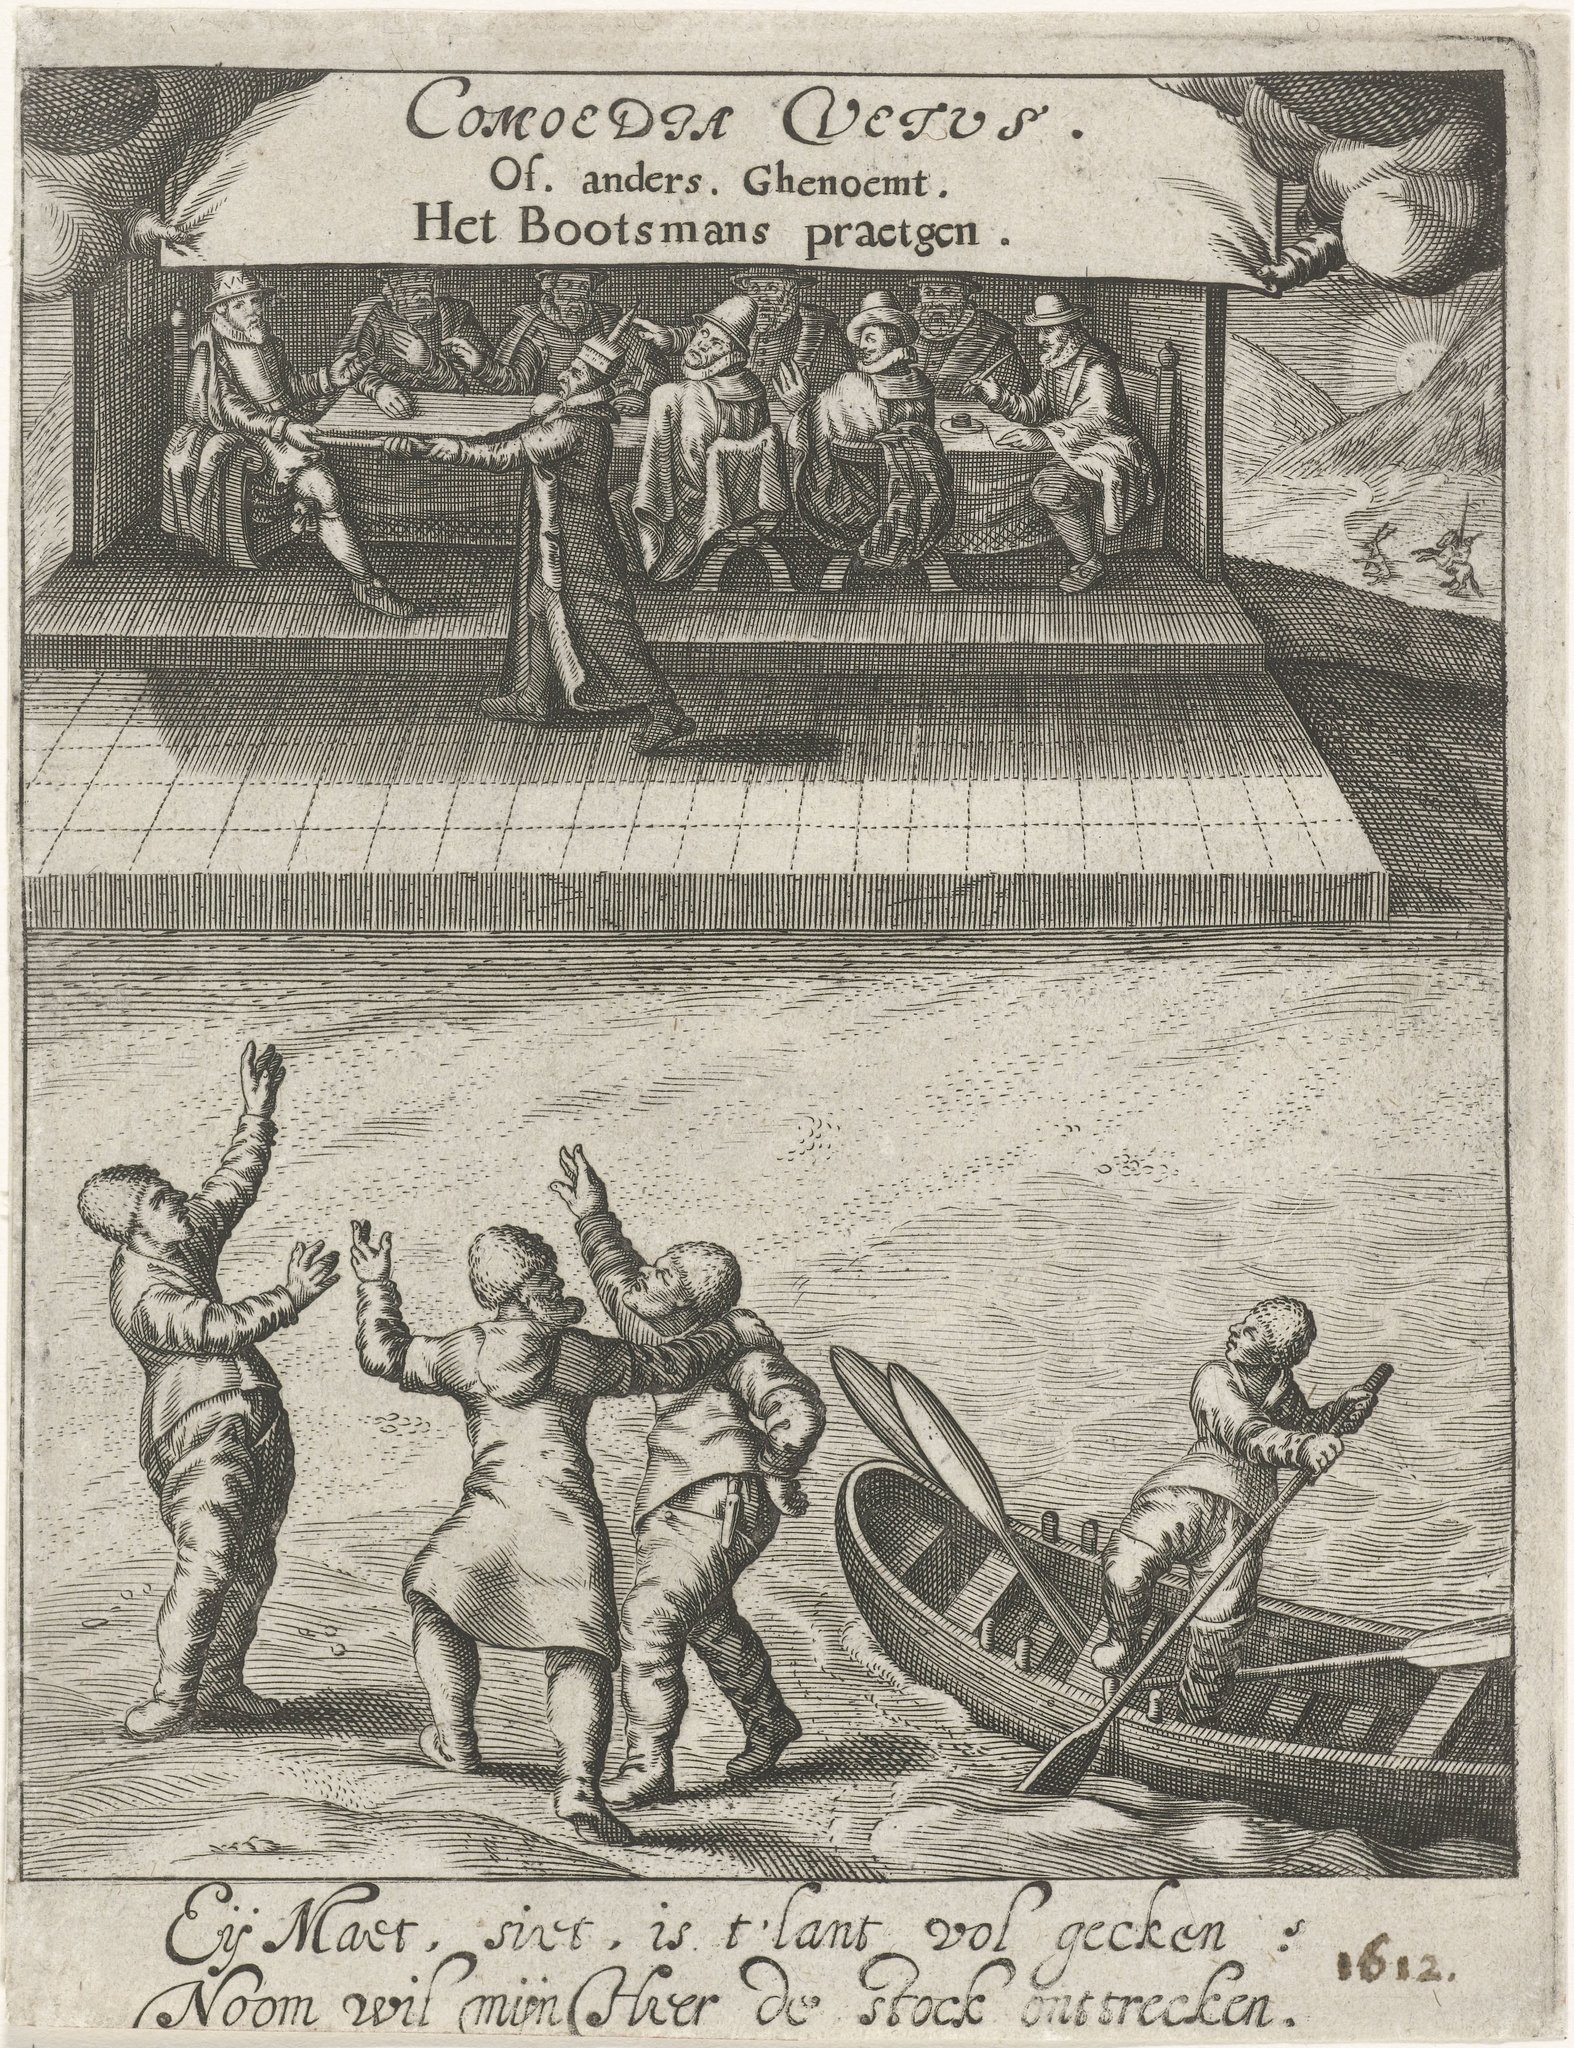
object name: titelprent, frontispice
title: Comoedia Vetus. Of. anders. Ghenoemt. Het Bootsmans praetgen.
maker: Anonymous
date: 1612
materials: paper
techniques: engraving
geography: northern netherlands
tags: the hague, maurice (prince of orange), seaman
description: Titelprent van het pamflet Comoedia Vetus, 1612. Bovenaan prins Maurits gezeten aan een tafel met zeven heren. Hij houdt een stok in de hand waarvan een man met een hoofddeksel in de vorm van een kerkgebouw aan het andere eind trekt. Op de voorgrond komen enkele matrozen aan land en wijzen in verbazing naar het bovenstaande tafereel. Met onderschrift van 2 regels in het Nederlands.